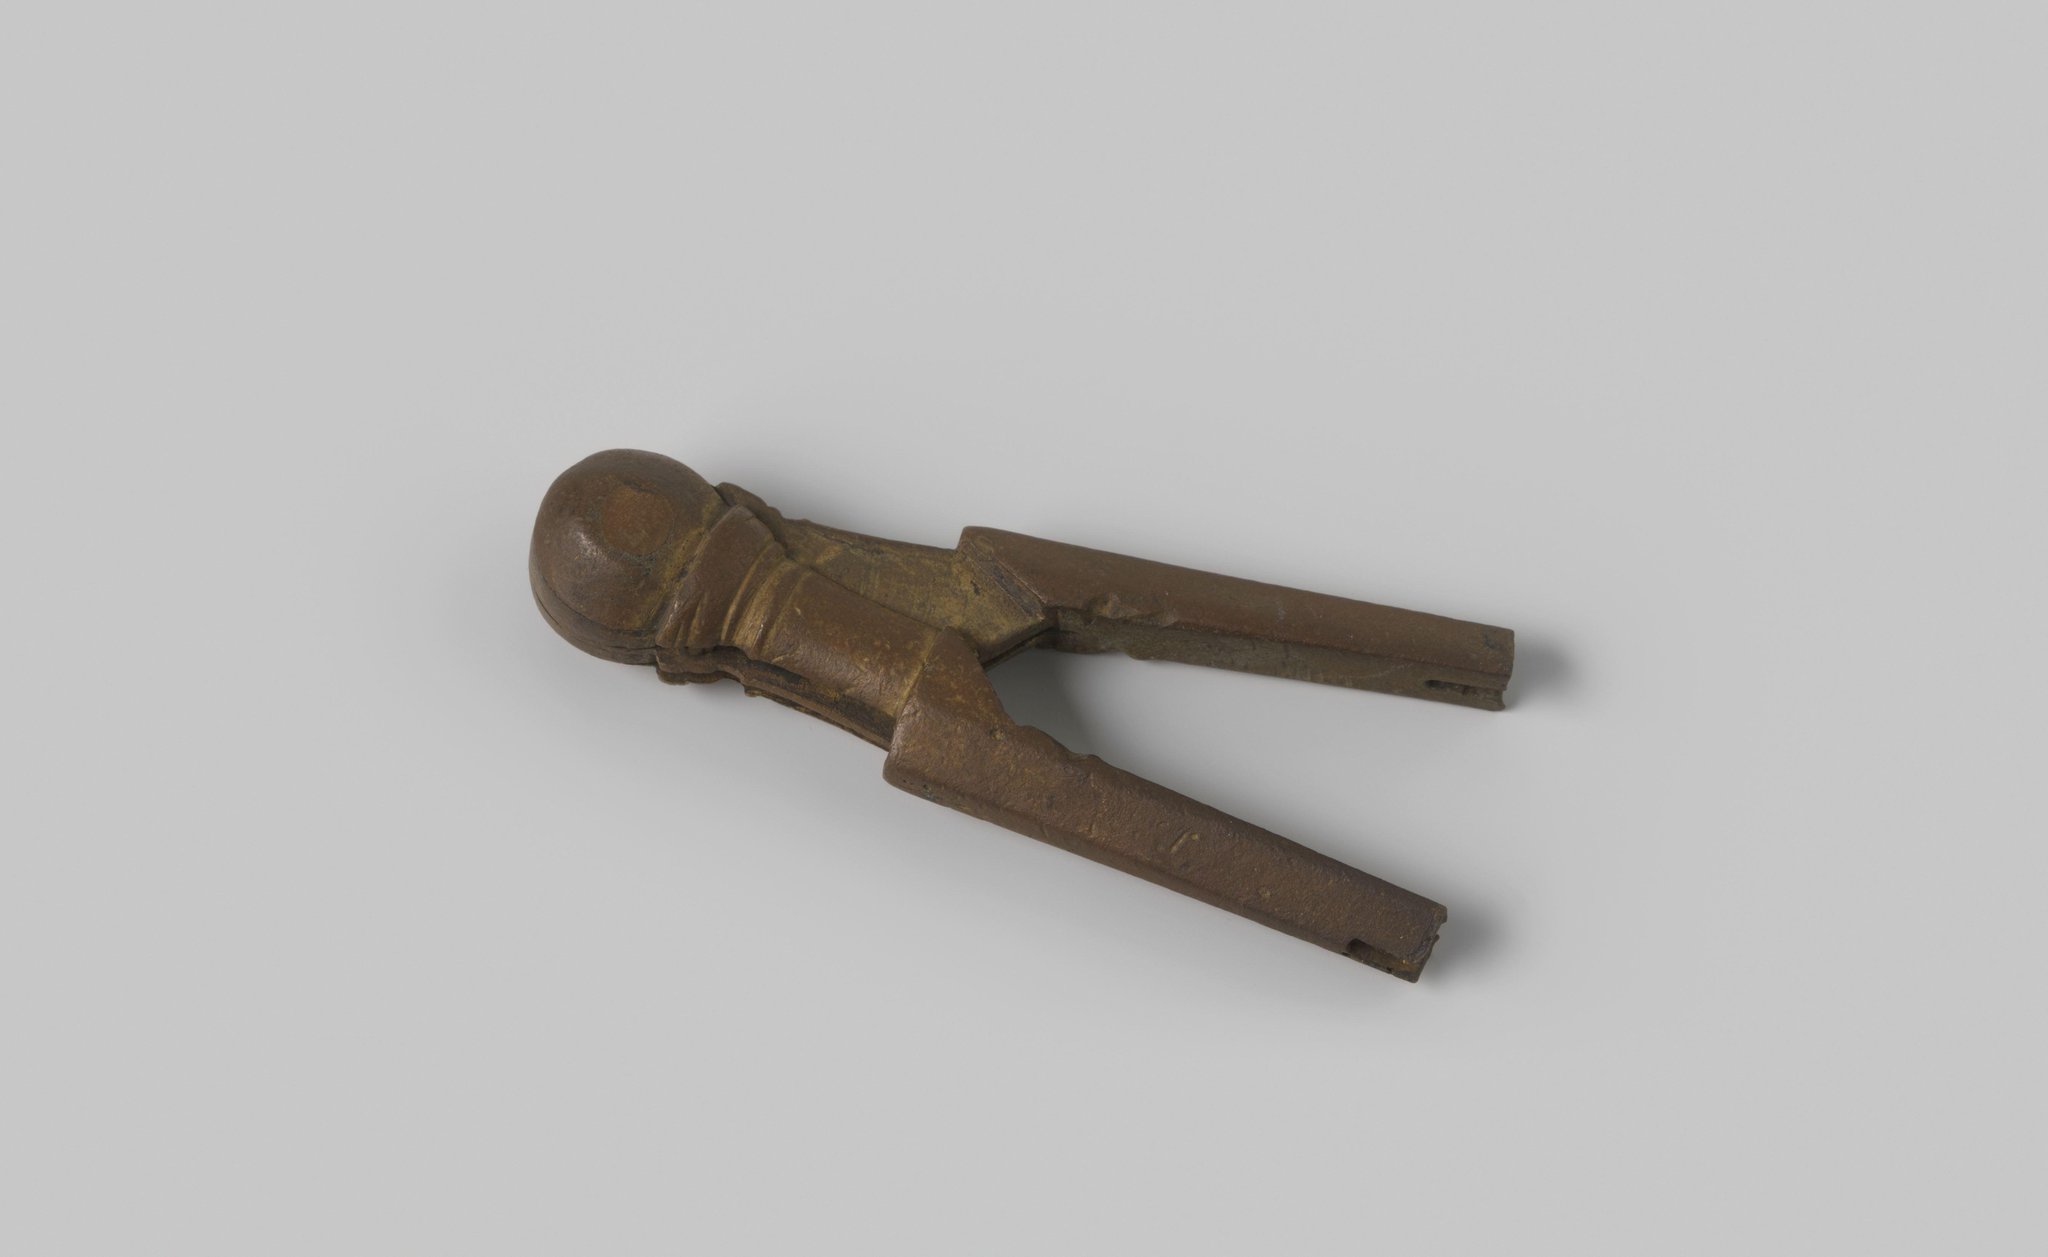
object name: divider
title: Steekpasser uit het wrak van de in 1735 vergane Oost-Indiëvaarder 't Vliegend Hart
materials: copper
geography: netherlands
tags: 't vliegend hart (schip), verenigde oostindische compagnie